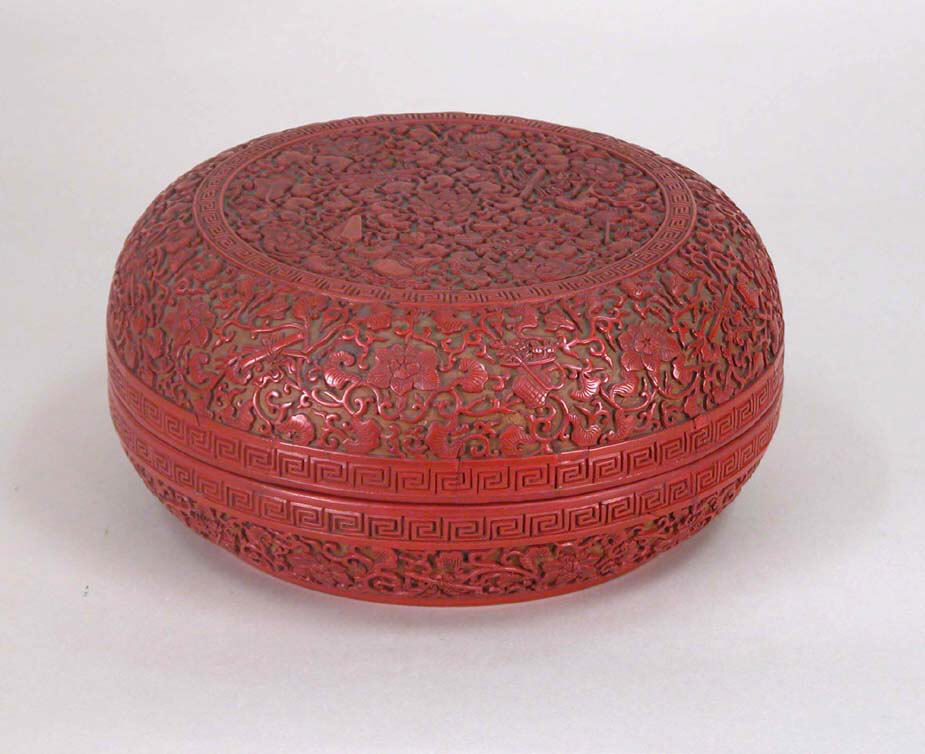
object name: box with cover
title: Box with Eight Buddhist Treasures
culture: chinese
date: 1701-1900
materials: lacquer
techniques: carving